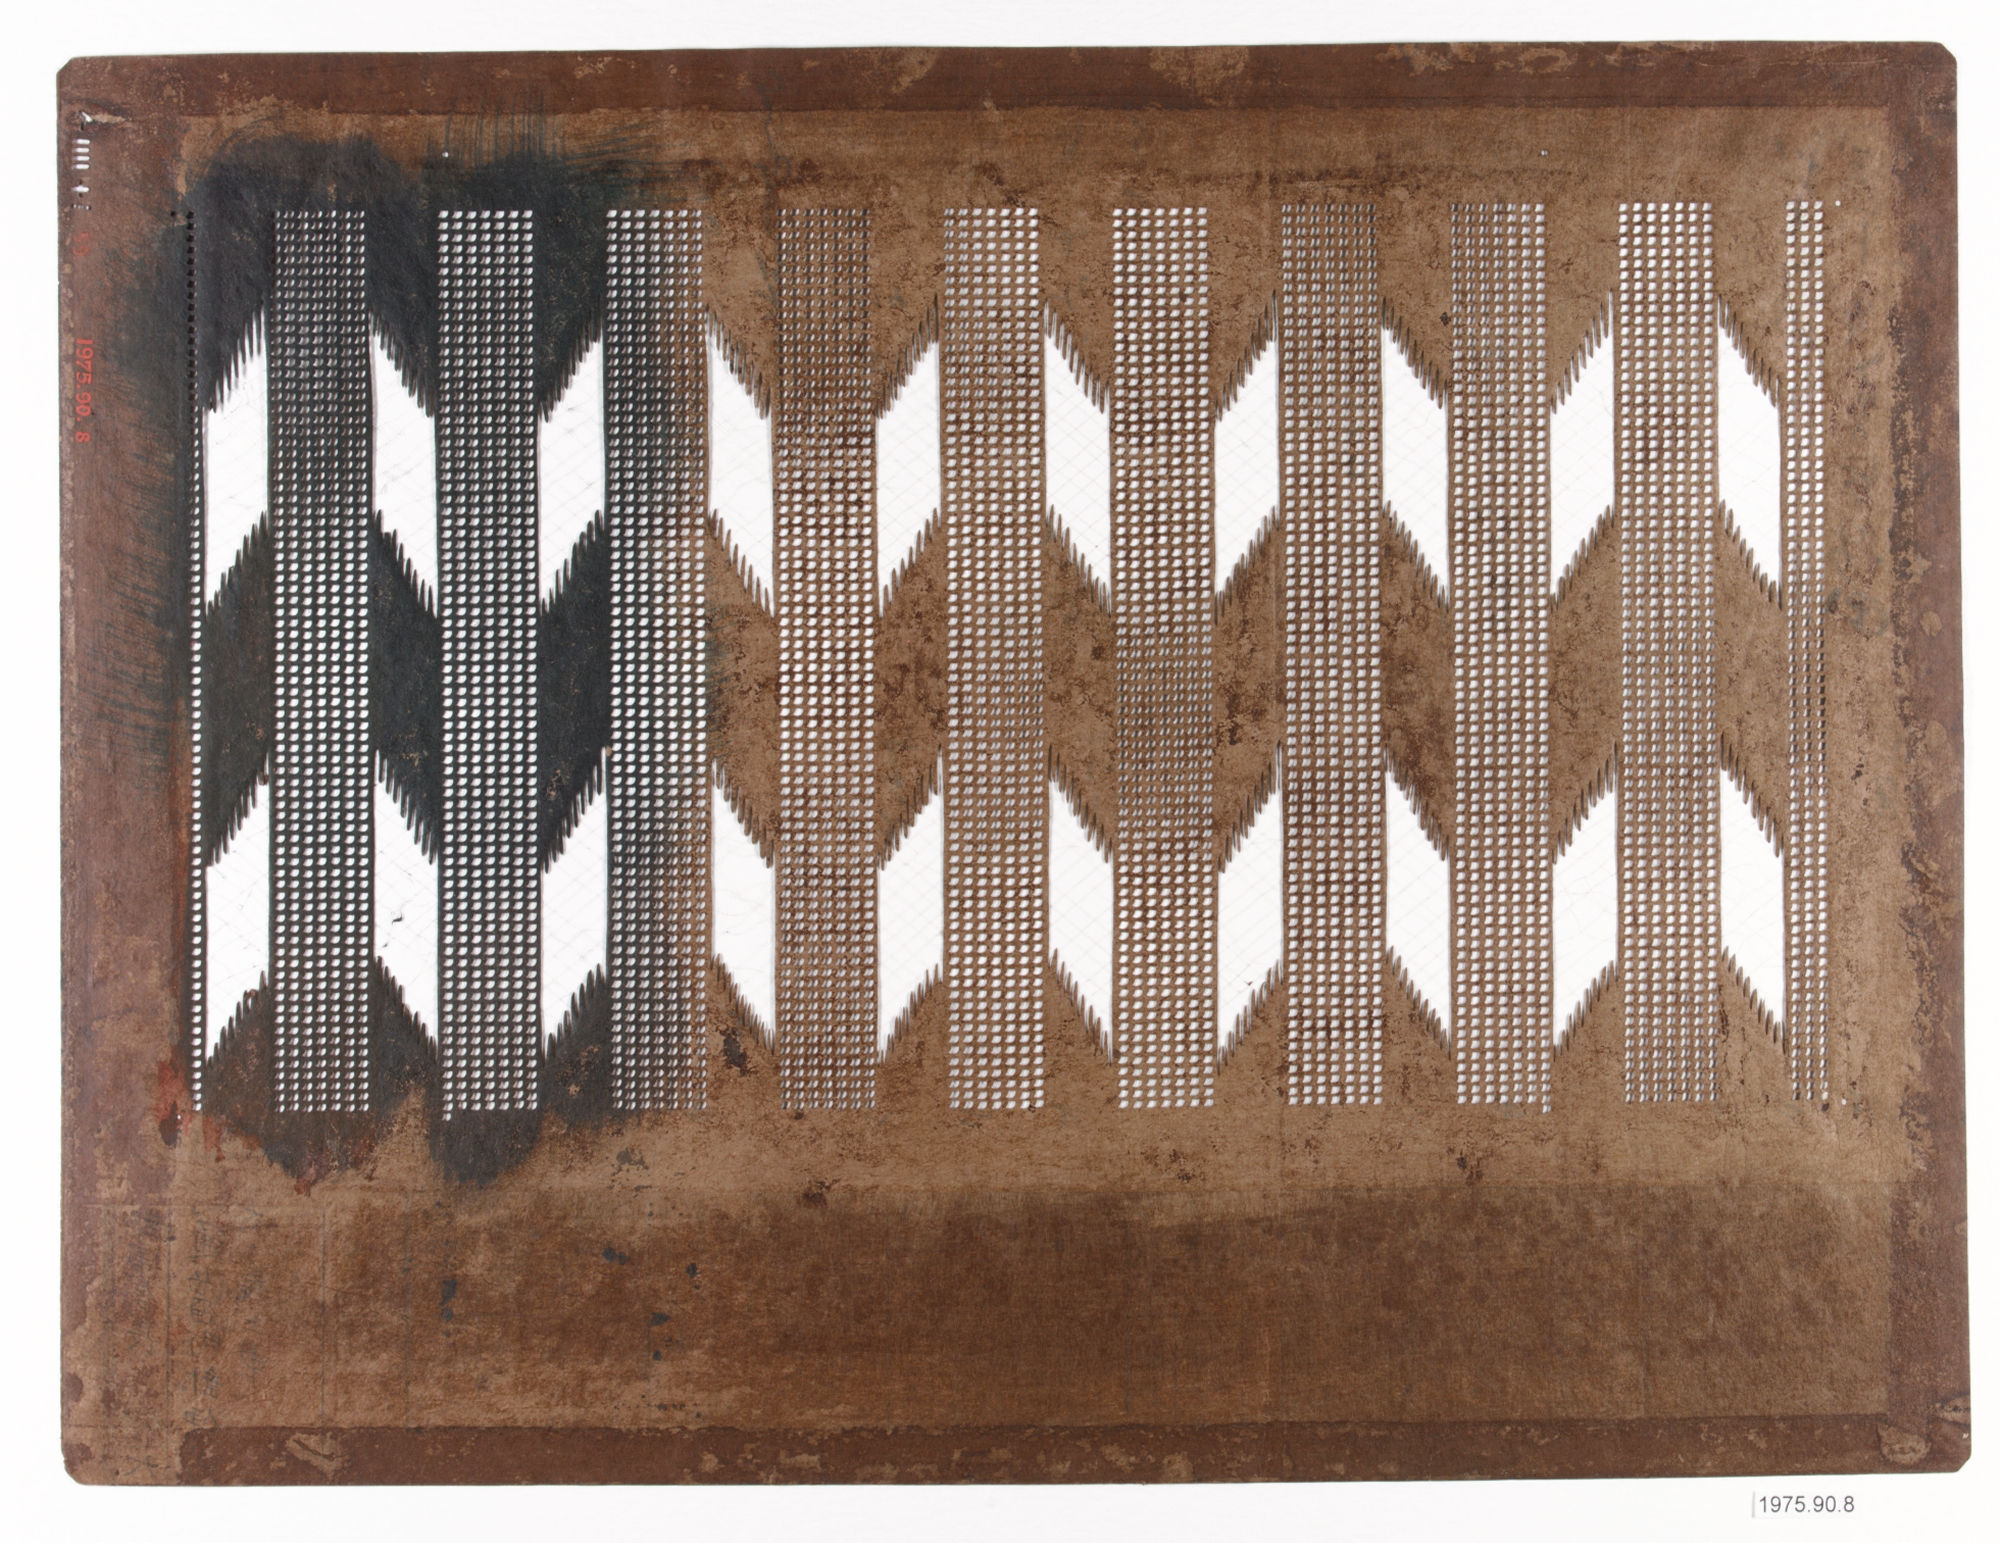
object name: stencil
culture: japanese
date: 1867-1933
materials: paper, silk